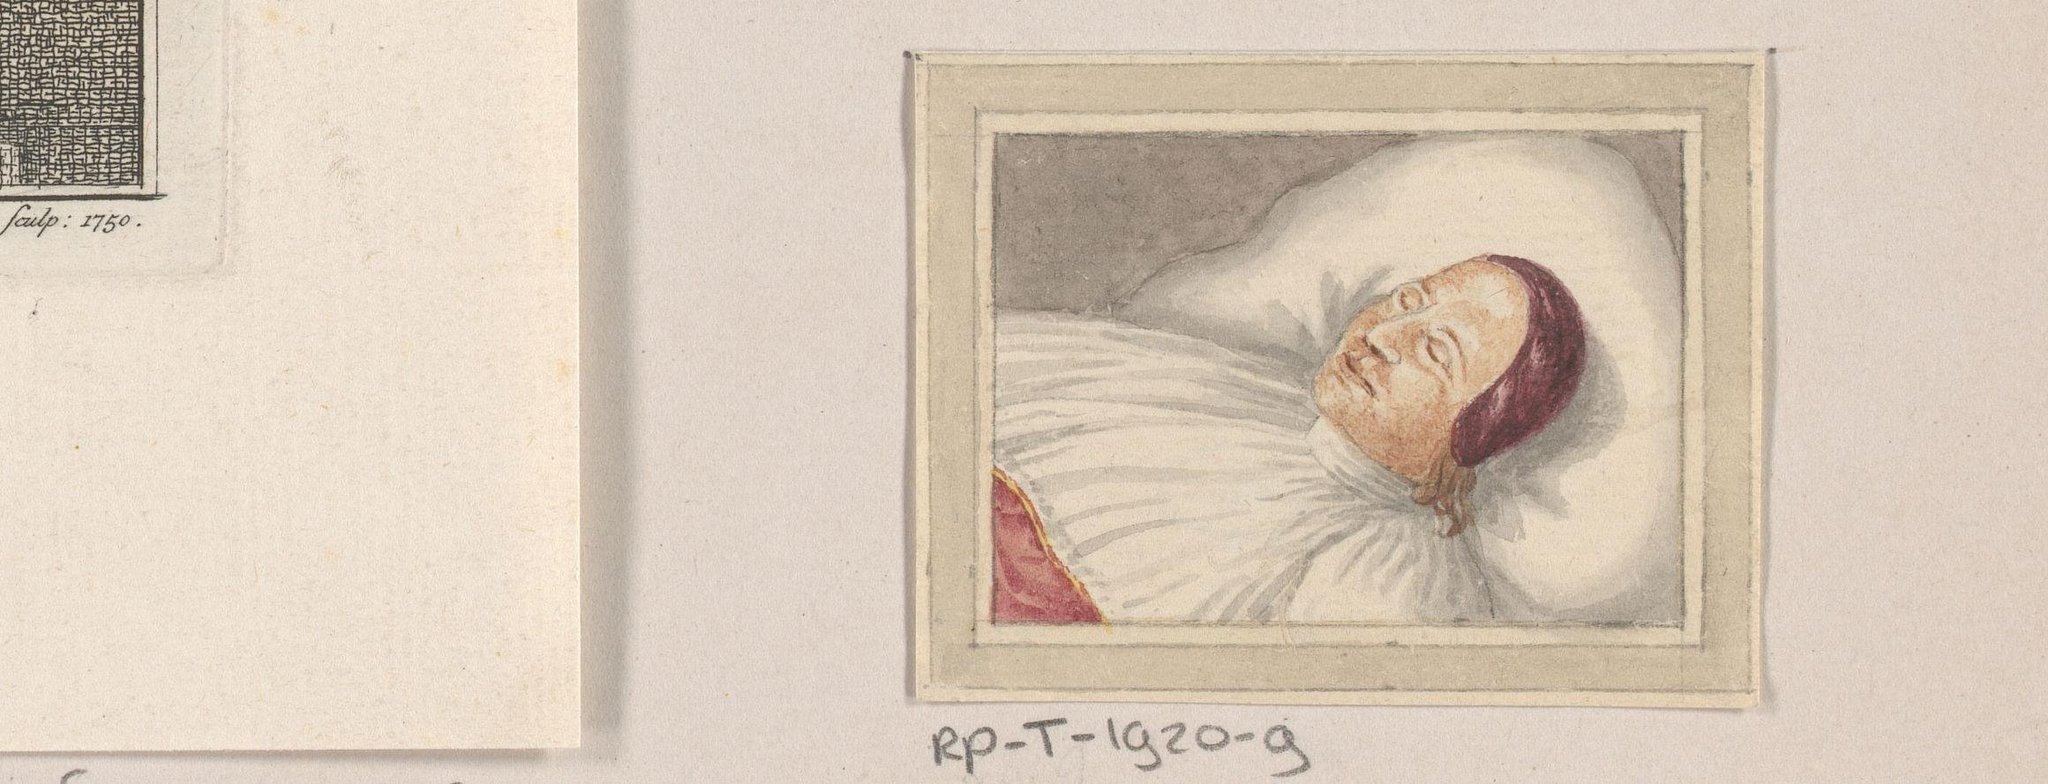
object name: drawing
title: Sterfbed van Nikolaus Ludwig Graf von Zinzendorf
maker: Anonymous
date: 1760-1762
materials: ink, paper, watercolor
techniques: brush, pen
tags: deathbed, historical persons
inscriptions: collector's mark: Lugt 2228